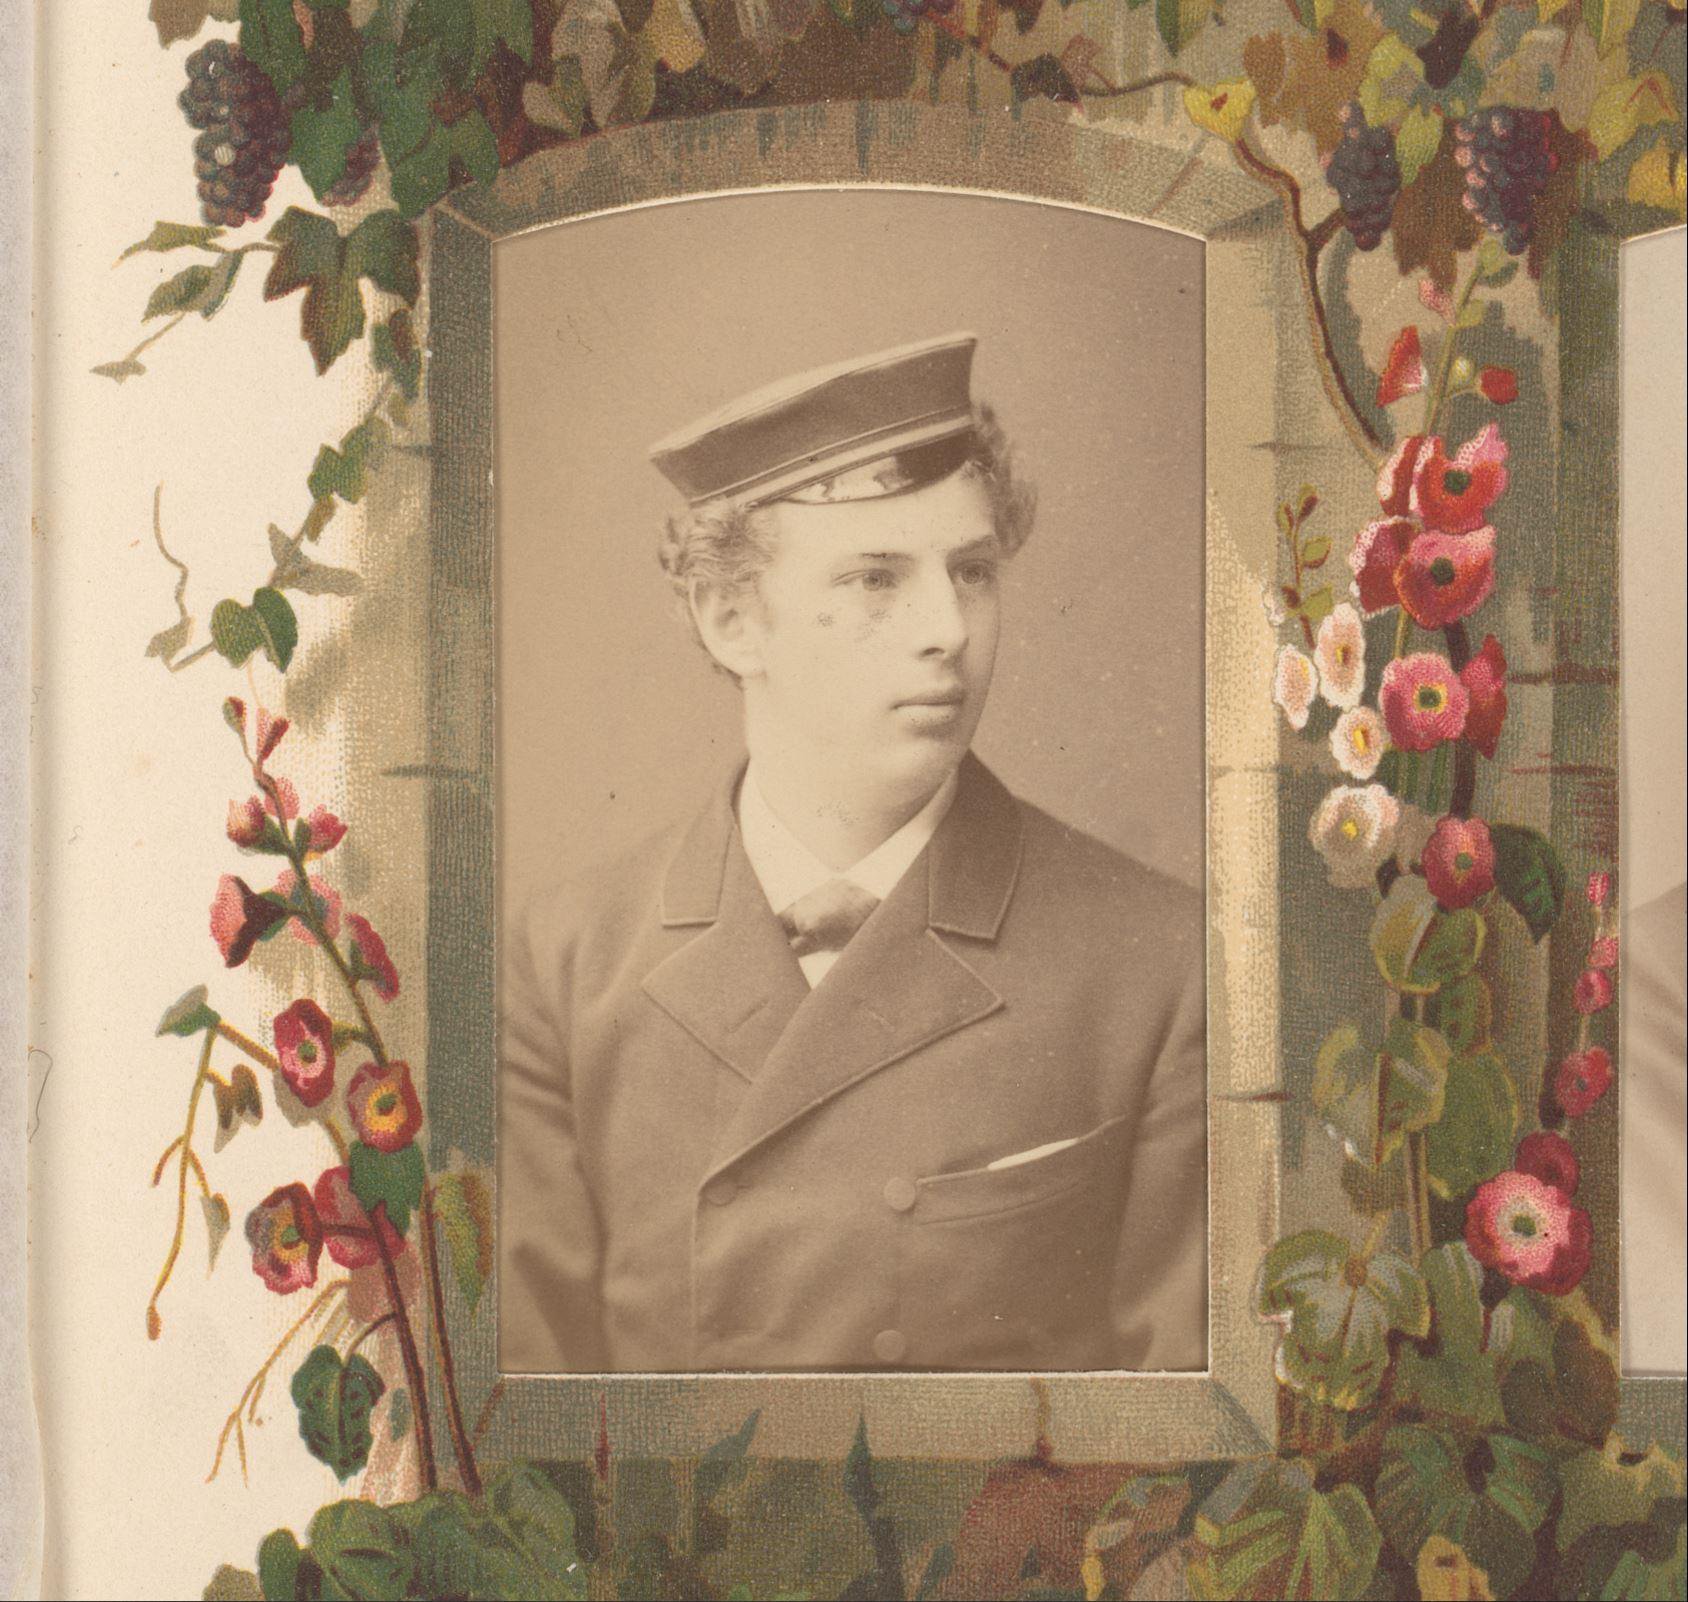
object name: carte de visite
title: Portret van een jonge man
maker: carl bräunlich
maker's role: fotograaf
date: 1850-1900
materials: cardboard, photographic support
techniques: albumen print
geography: jena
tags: historical persons, youth, adolescent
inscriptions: annotation: ‘zur Erinnerung an s/[.] treu[..]/ Freunde Gustav’, inscription: ‘CARL BRÄUNLICH/ (...)/ HERZOGL. SACHS ALTERNBURG HOF PHOTOGRAPH/ JENA/ AM HOLZMARKT.’